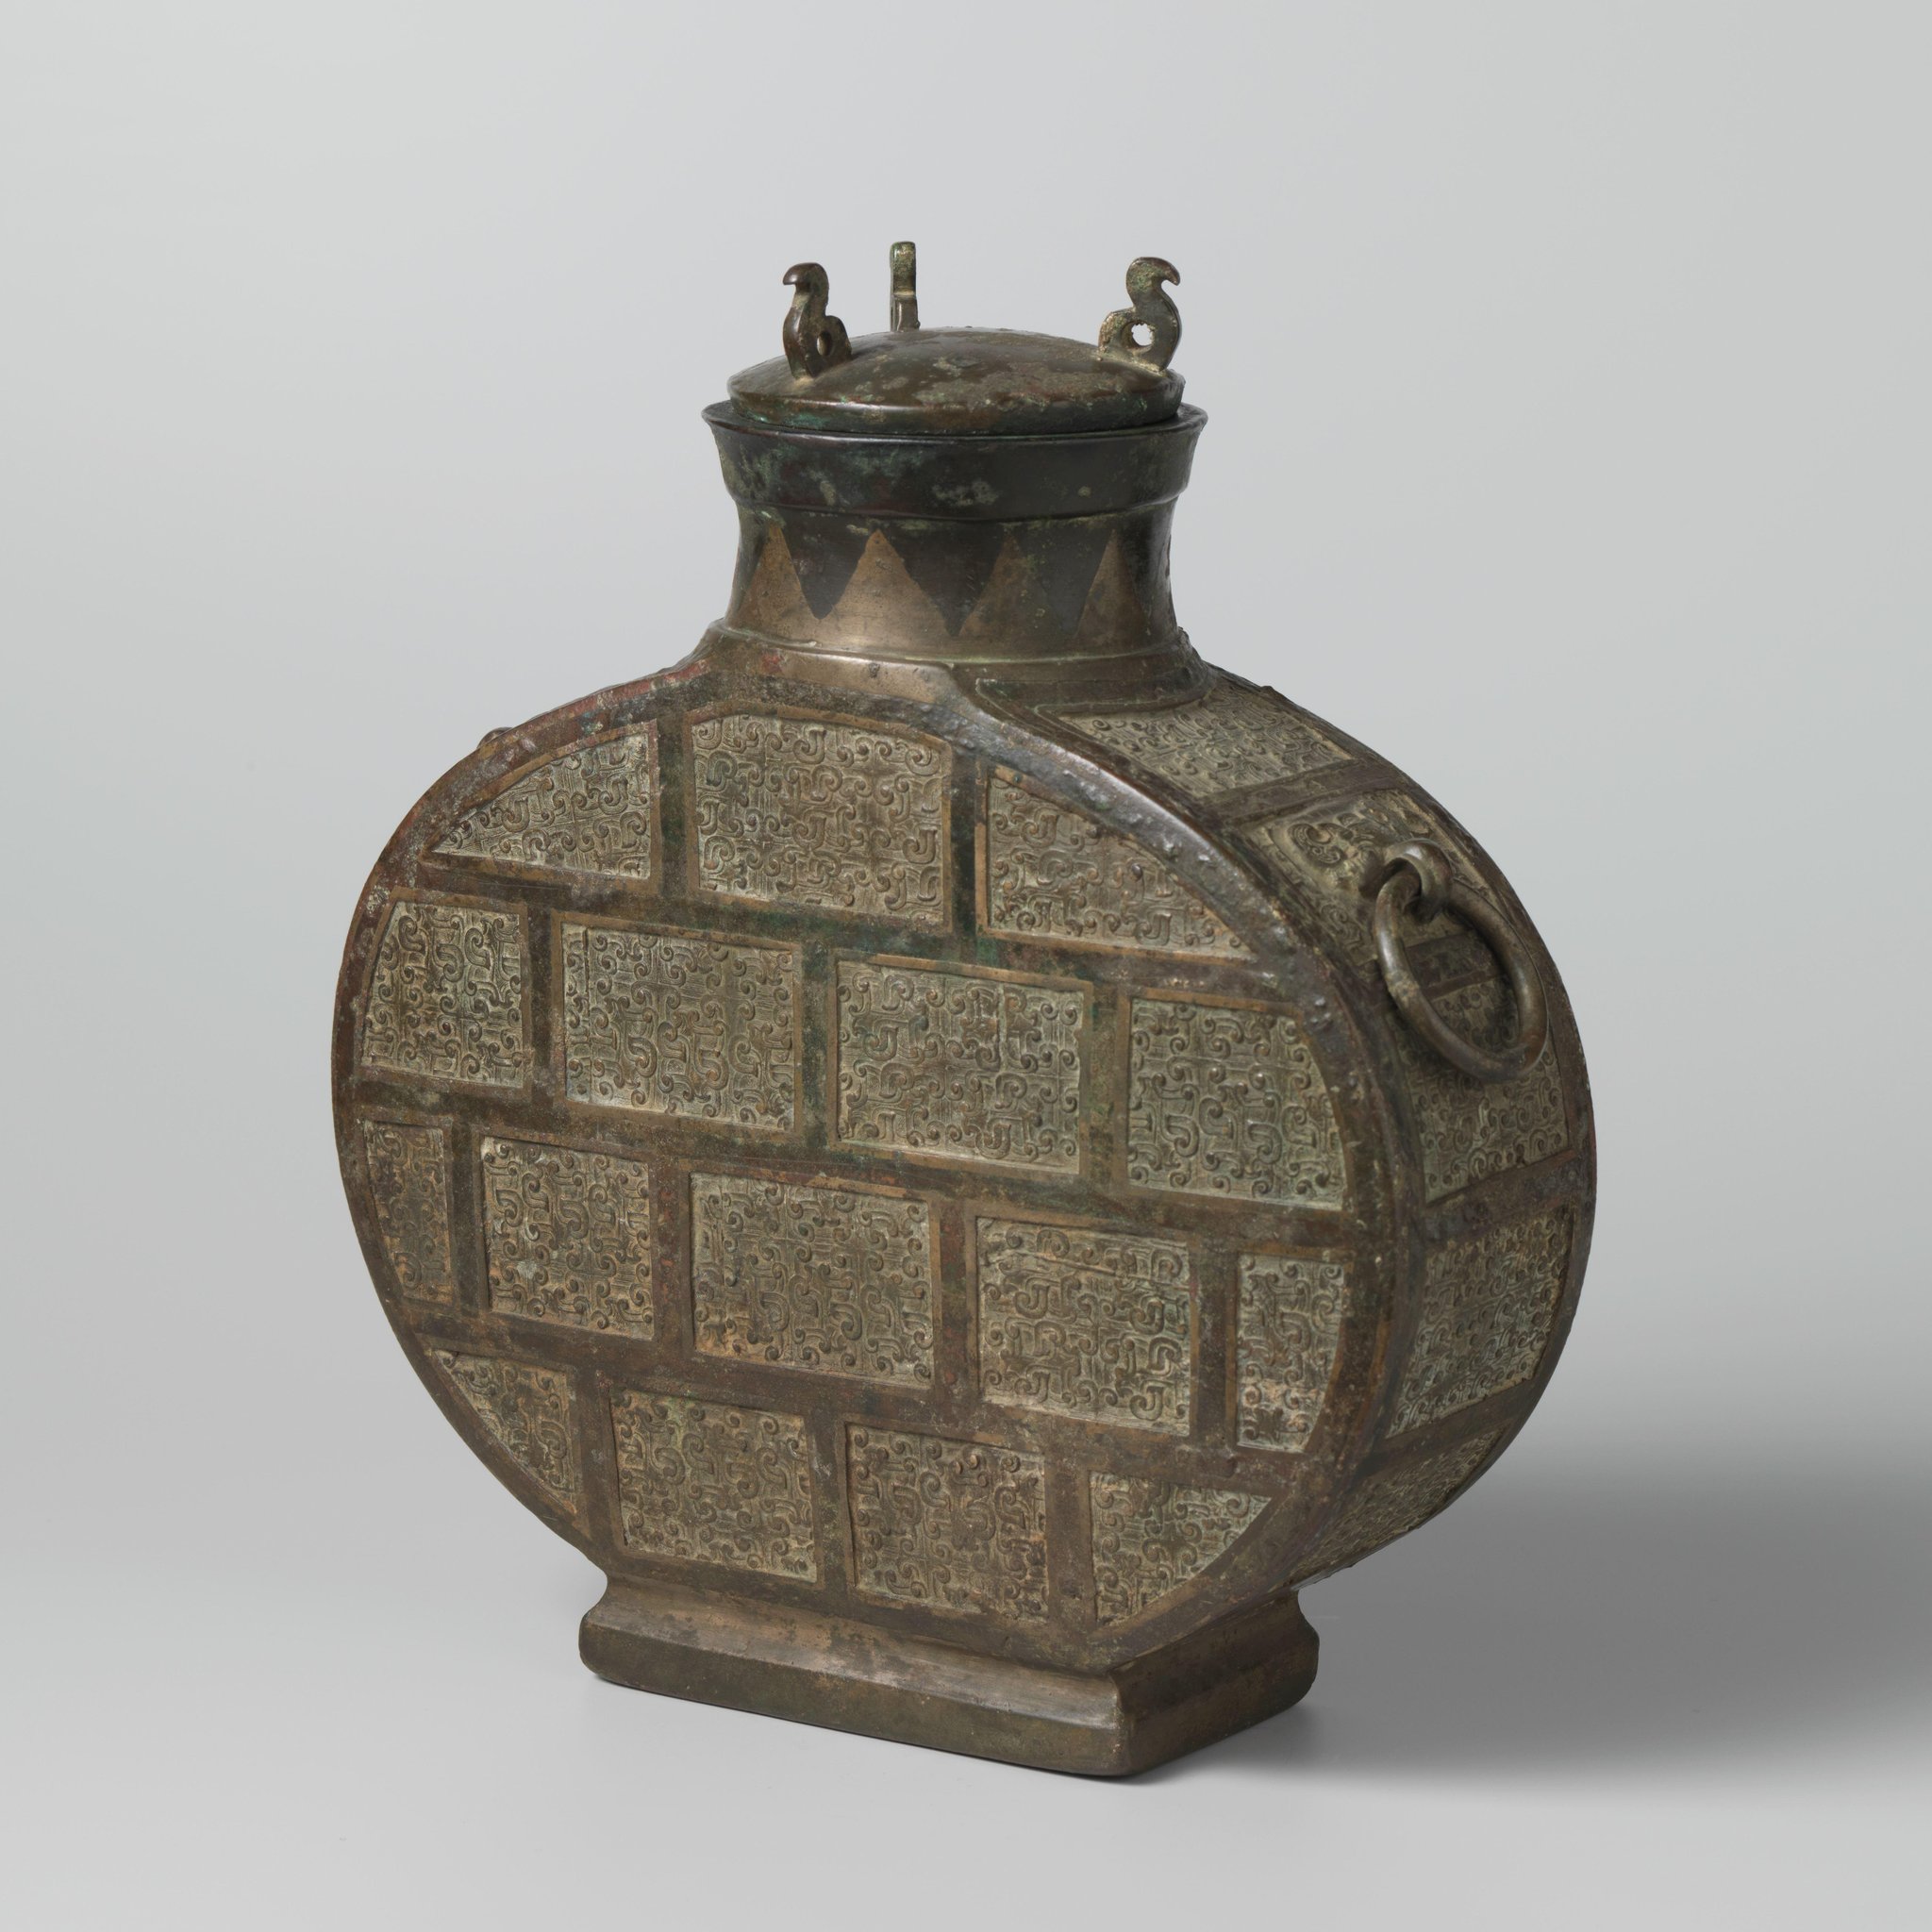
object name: bottle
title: Ritual flask and wine vessel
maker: Anonymous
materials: bronze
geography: china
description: Deksel van platte fles (platte zijde verdeeld in rechthoeken).